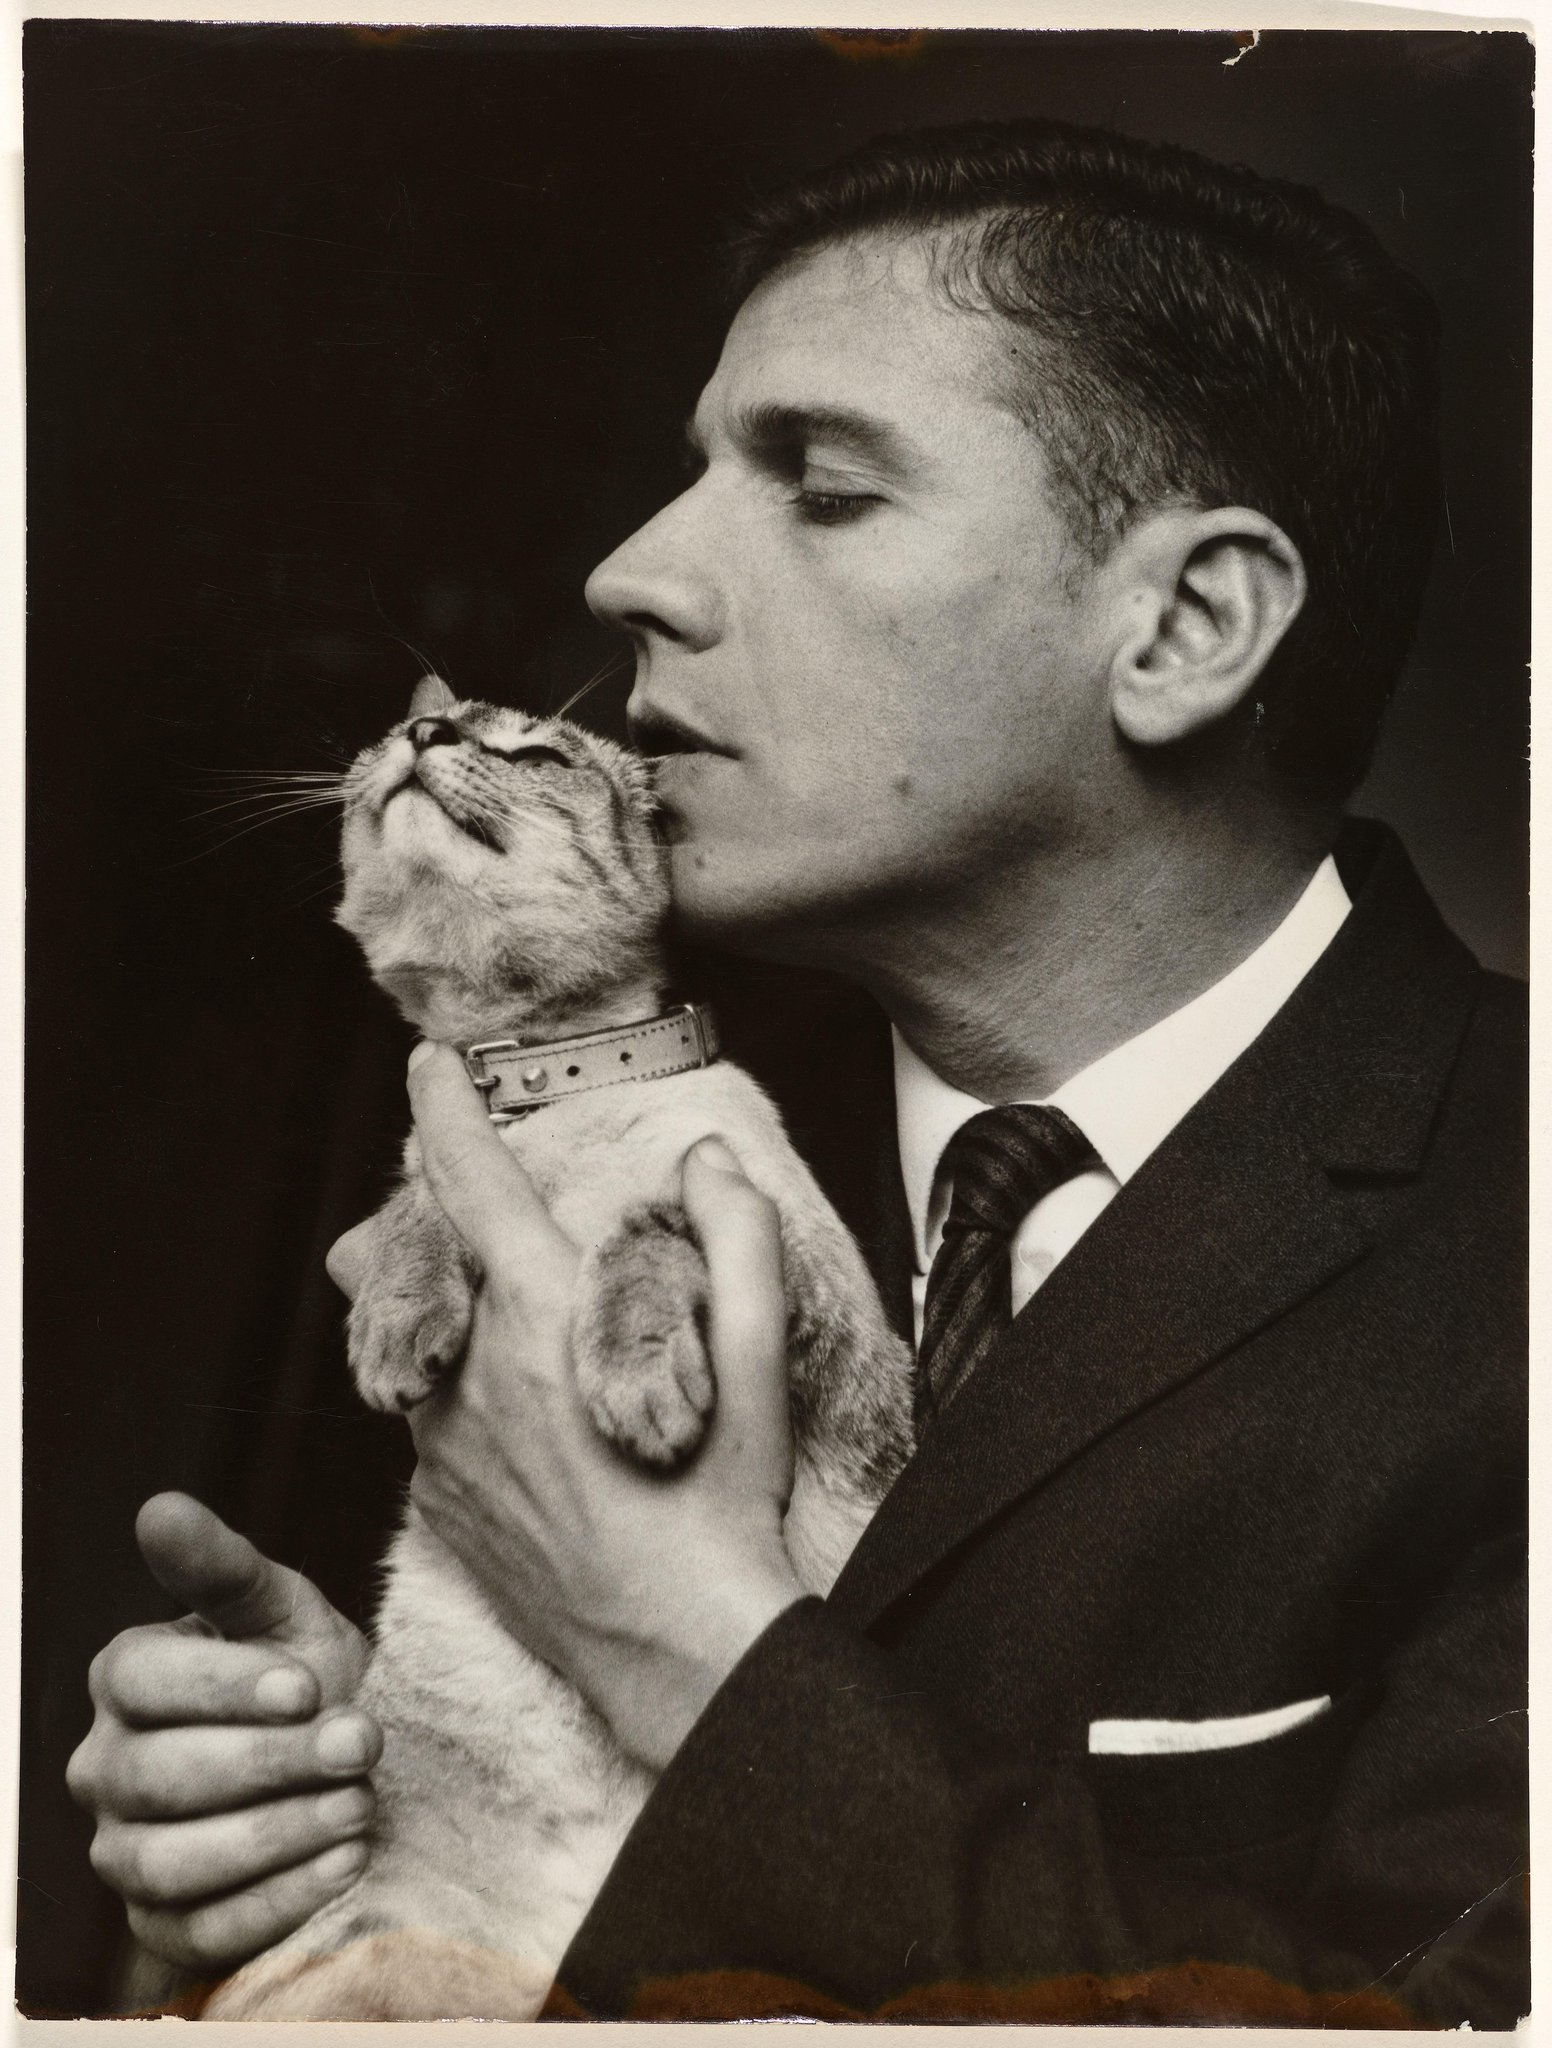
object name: photograph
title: Gerard Reve met de half-siamese poes Justine (genoemd naar De Sade)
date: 1968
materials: paper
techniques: gelatin silver print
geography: netherlands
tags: amsterdam, belgium, portrait of a writer